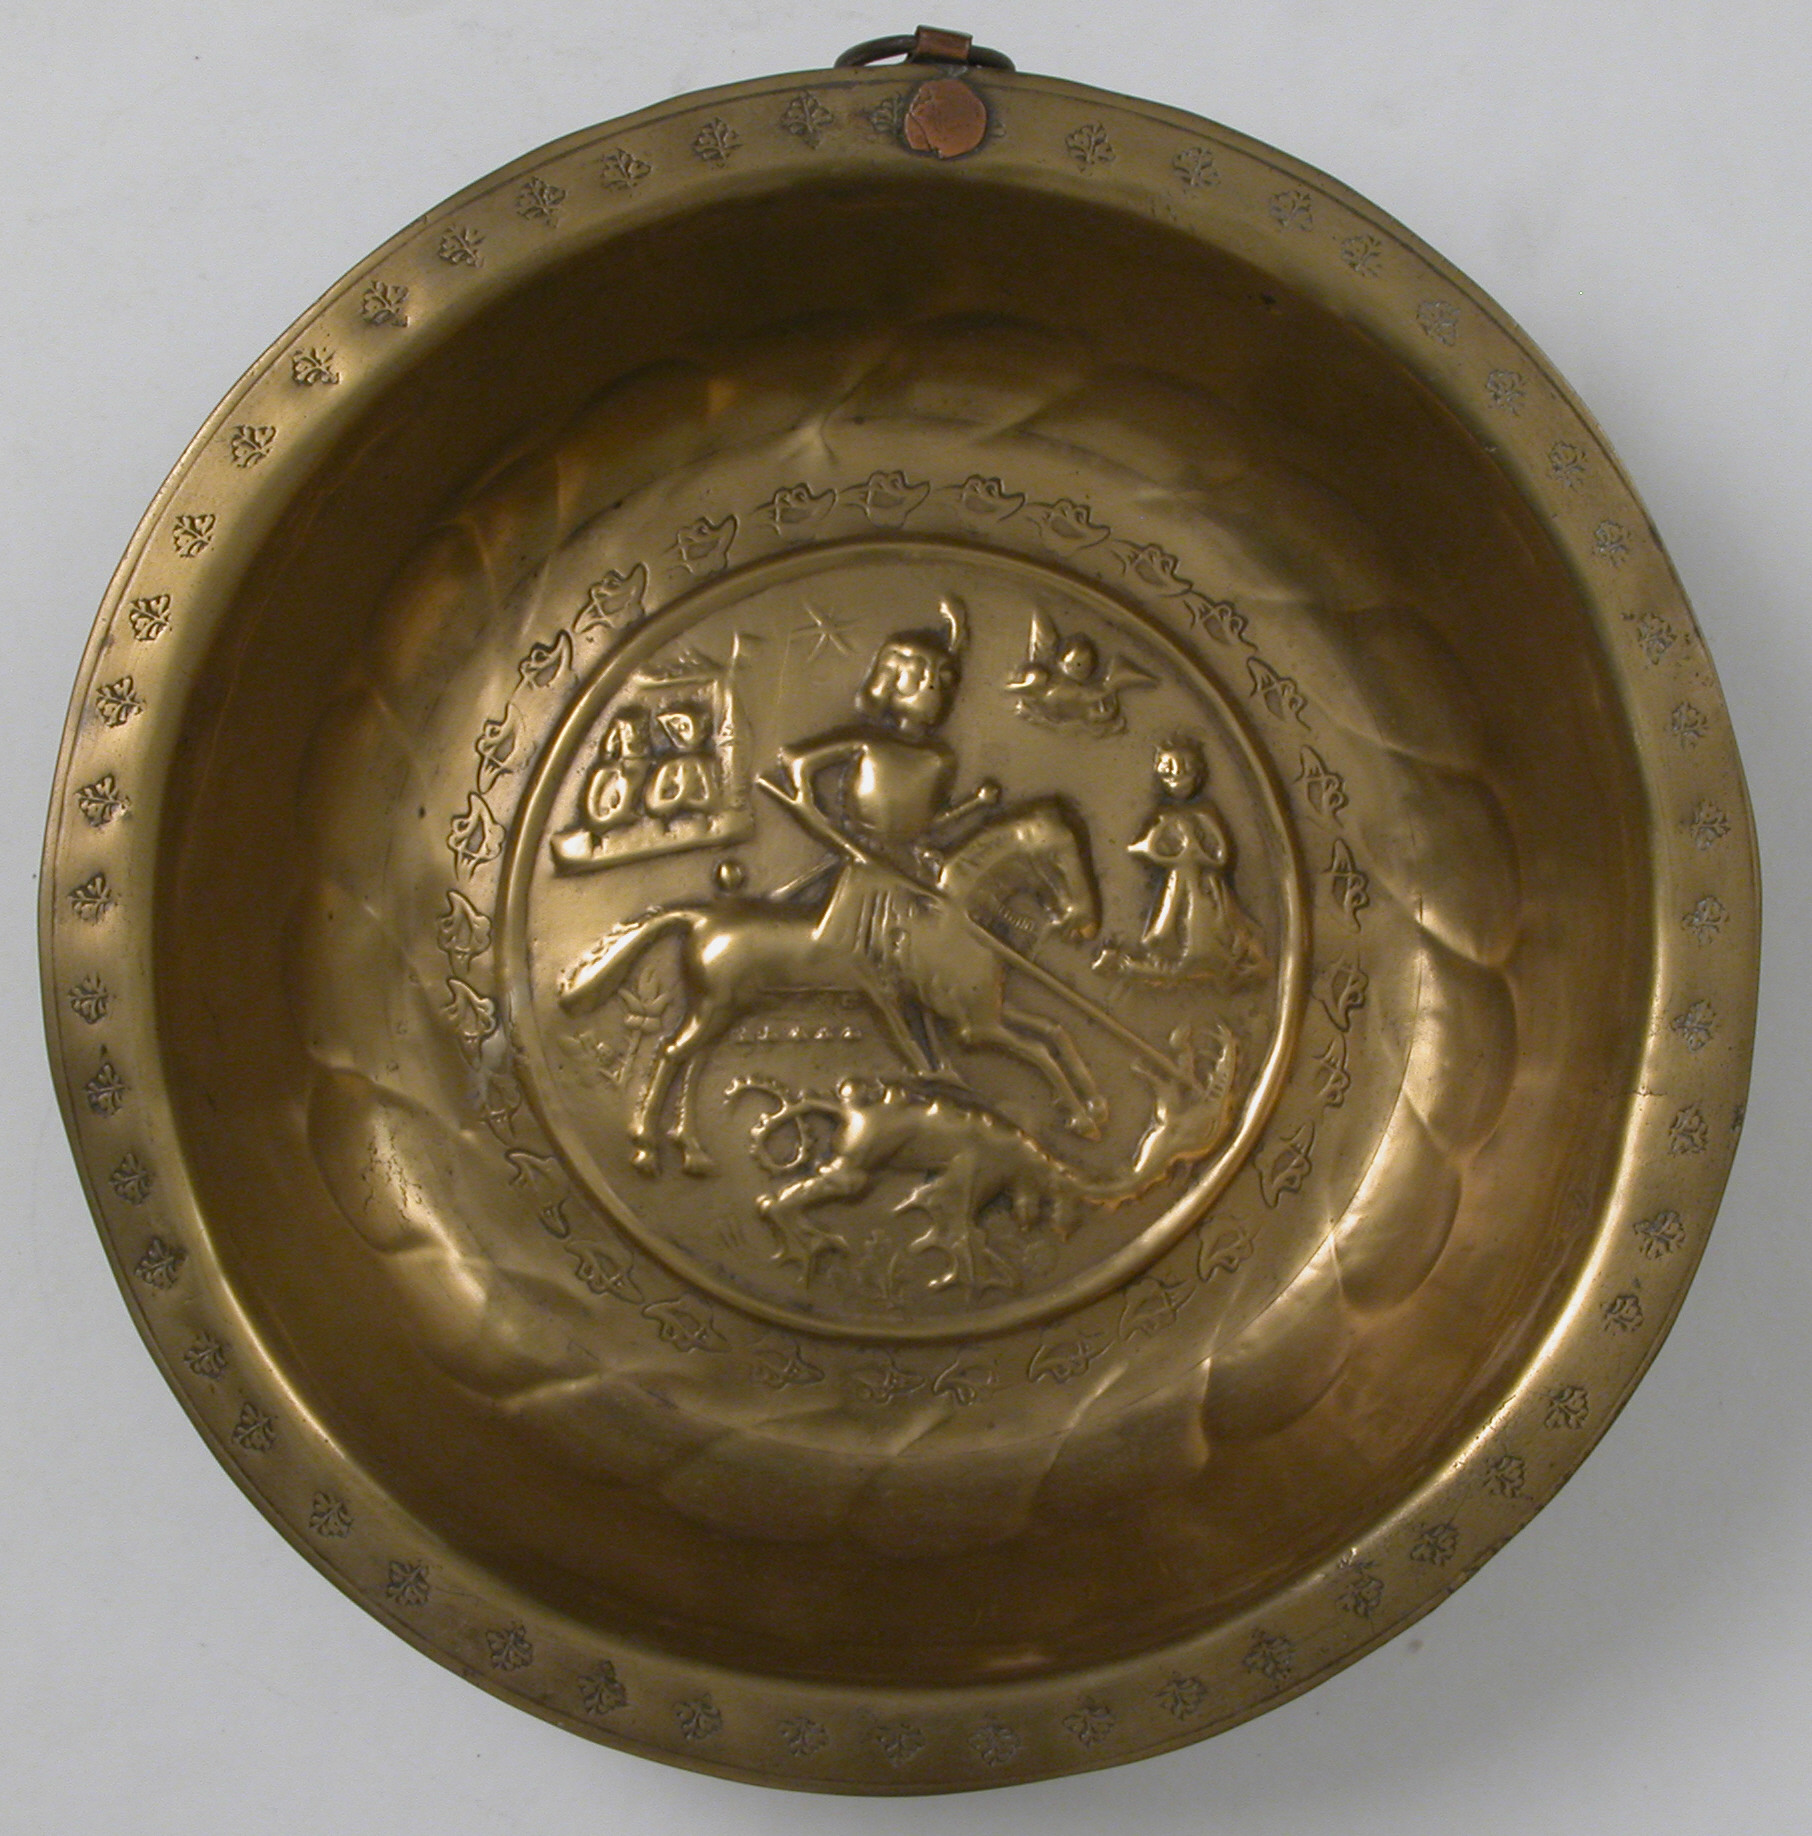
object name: dish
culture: german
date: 1501-1533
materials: brass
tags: human figures,horses